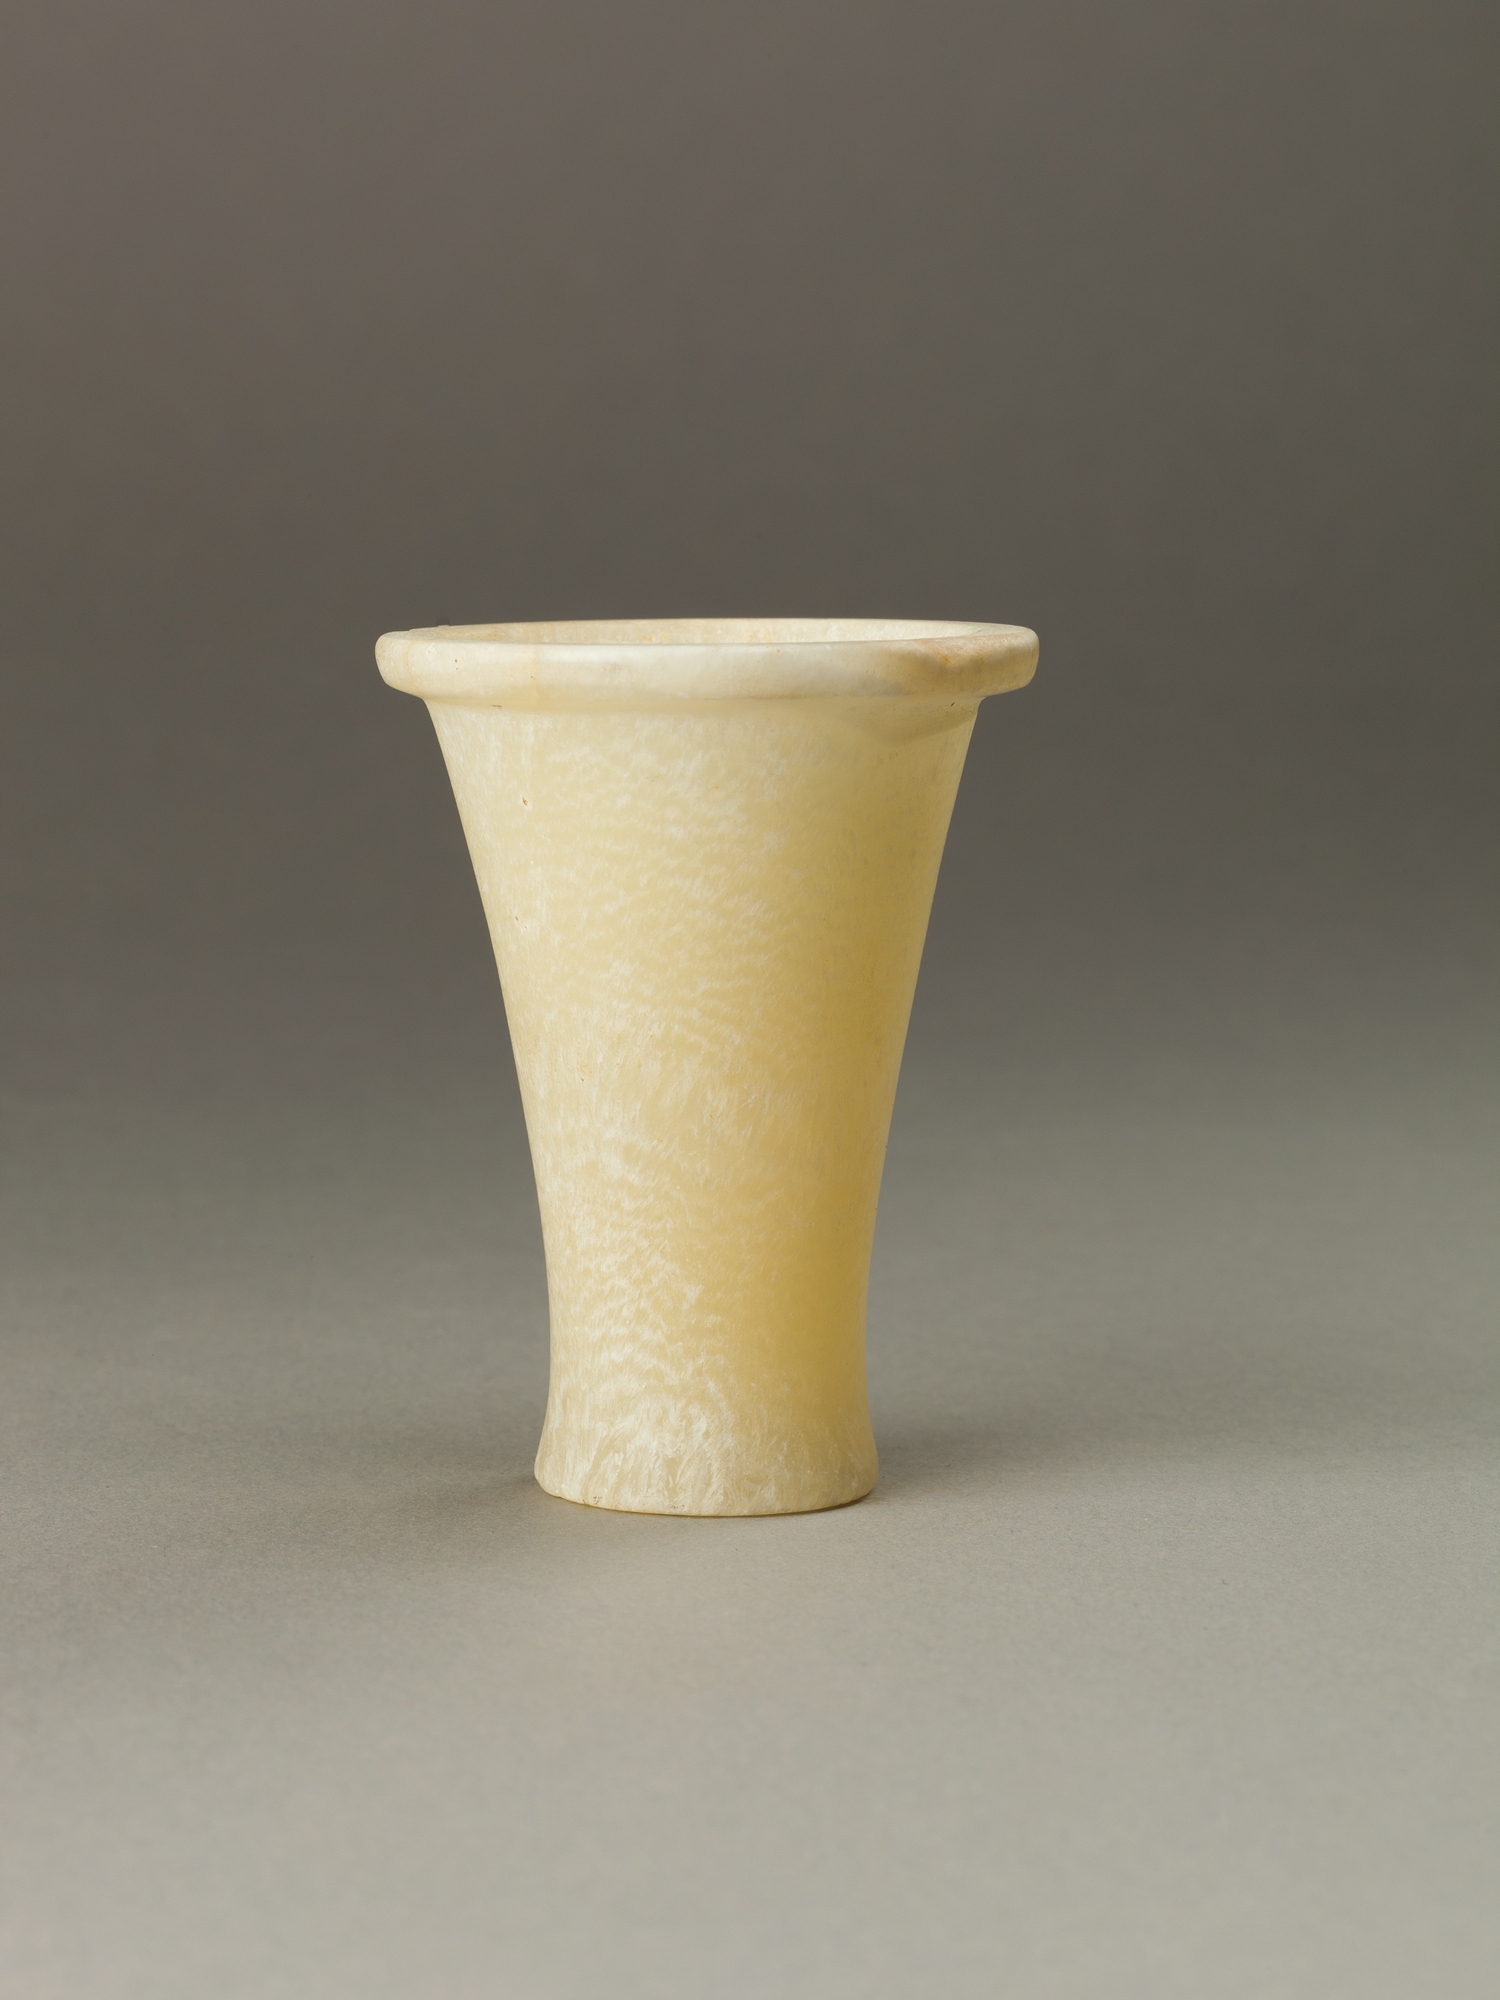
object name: ointment jar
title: Cosmetic jar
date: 1805 BCE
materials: stone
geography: egypt